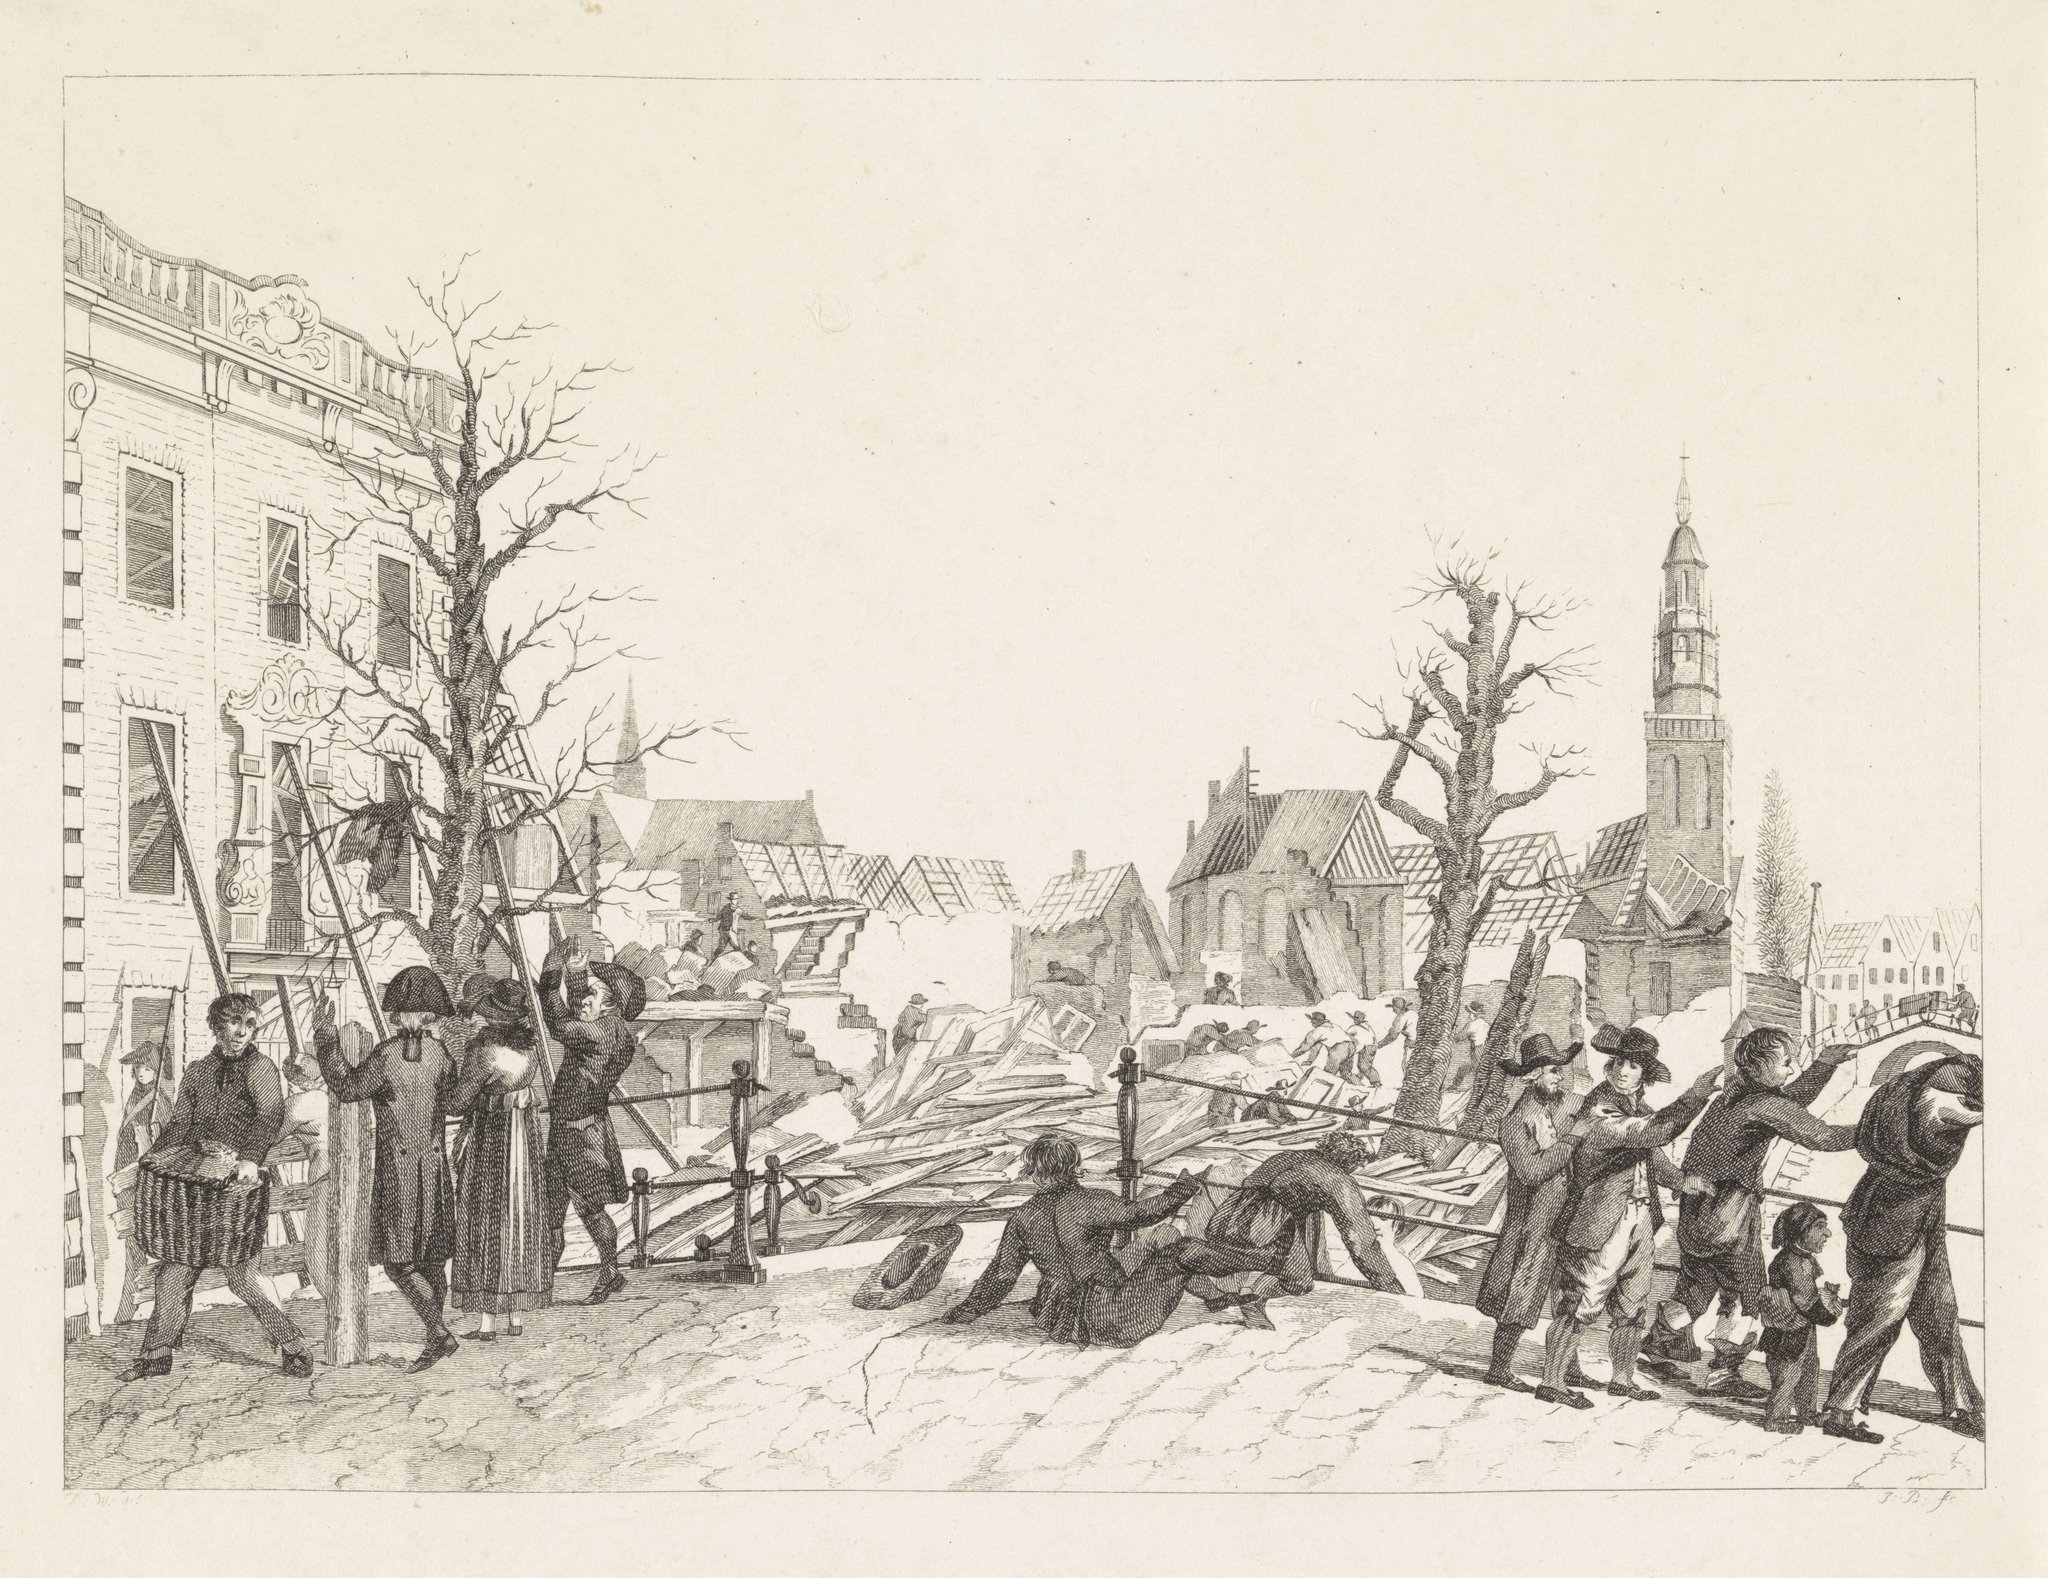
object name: print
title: Ruïnes te Leiden na de buskruitramp, 1807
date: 1807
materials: paper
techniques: engraving, etching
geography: netherlands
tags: gunpowder disaster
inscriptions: collector's mark: Lugt 2228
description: Gezicht vanaf de Nieuwsteegbrug over het verwoest gebied op het Steenschuur te Leiden na de buskruitramp op 12 januari 1807. Links een gestut huis, in de verte de Saaihal. Zie ook de pendant.